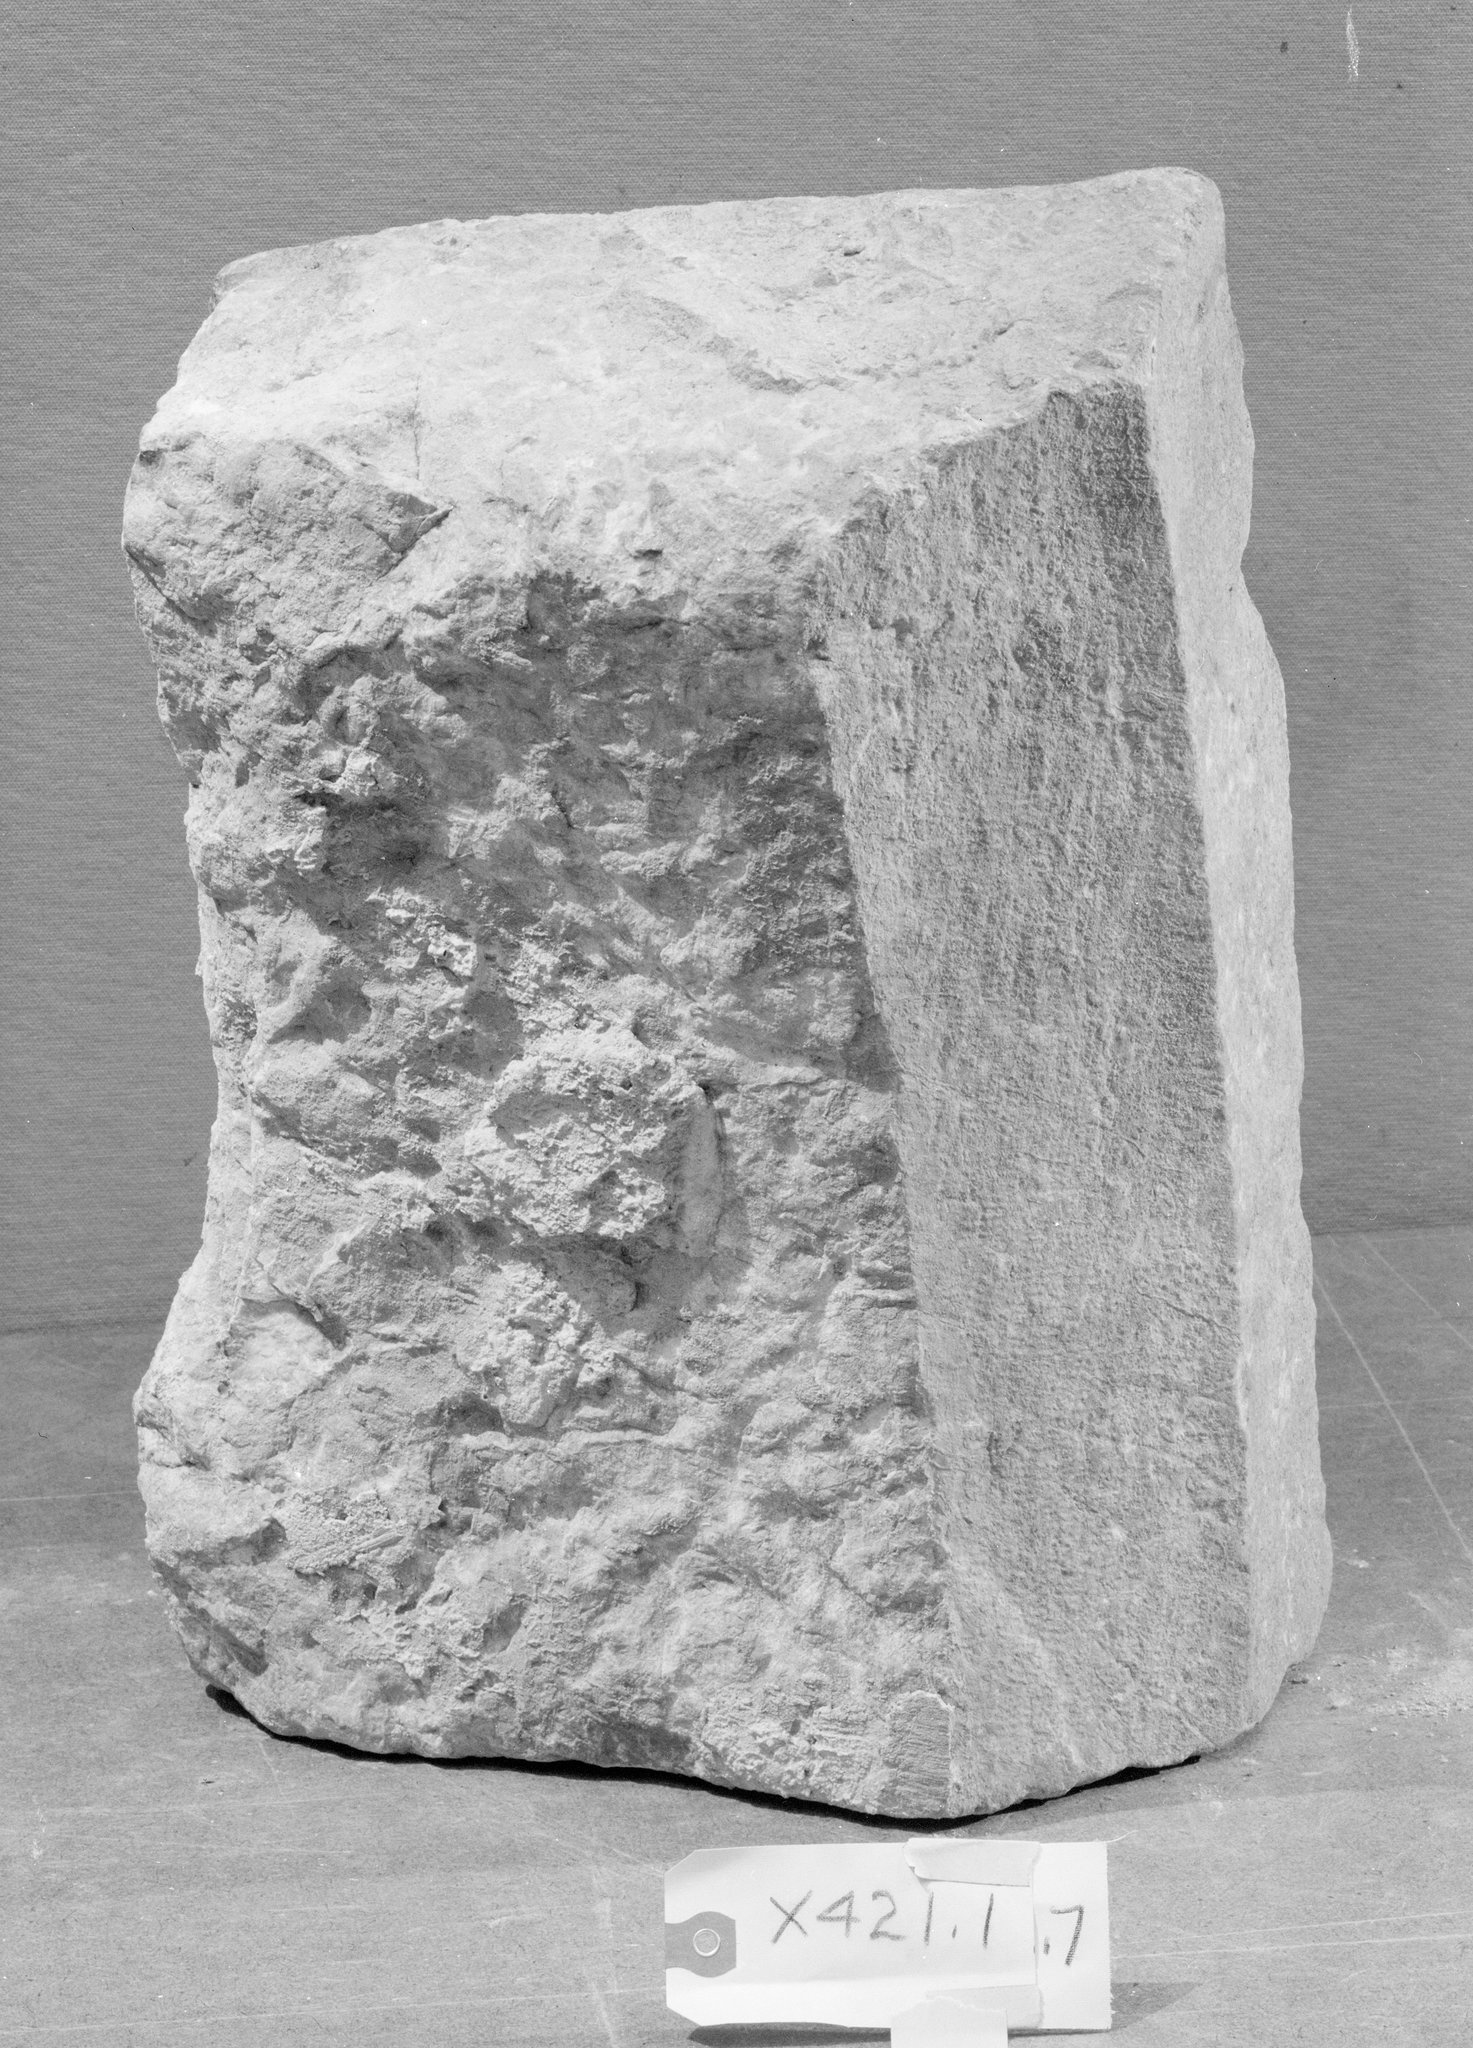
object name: block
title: Block Fragment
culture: french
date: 1130-1140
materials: stone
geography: france